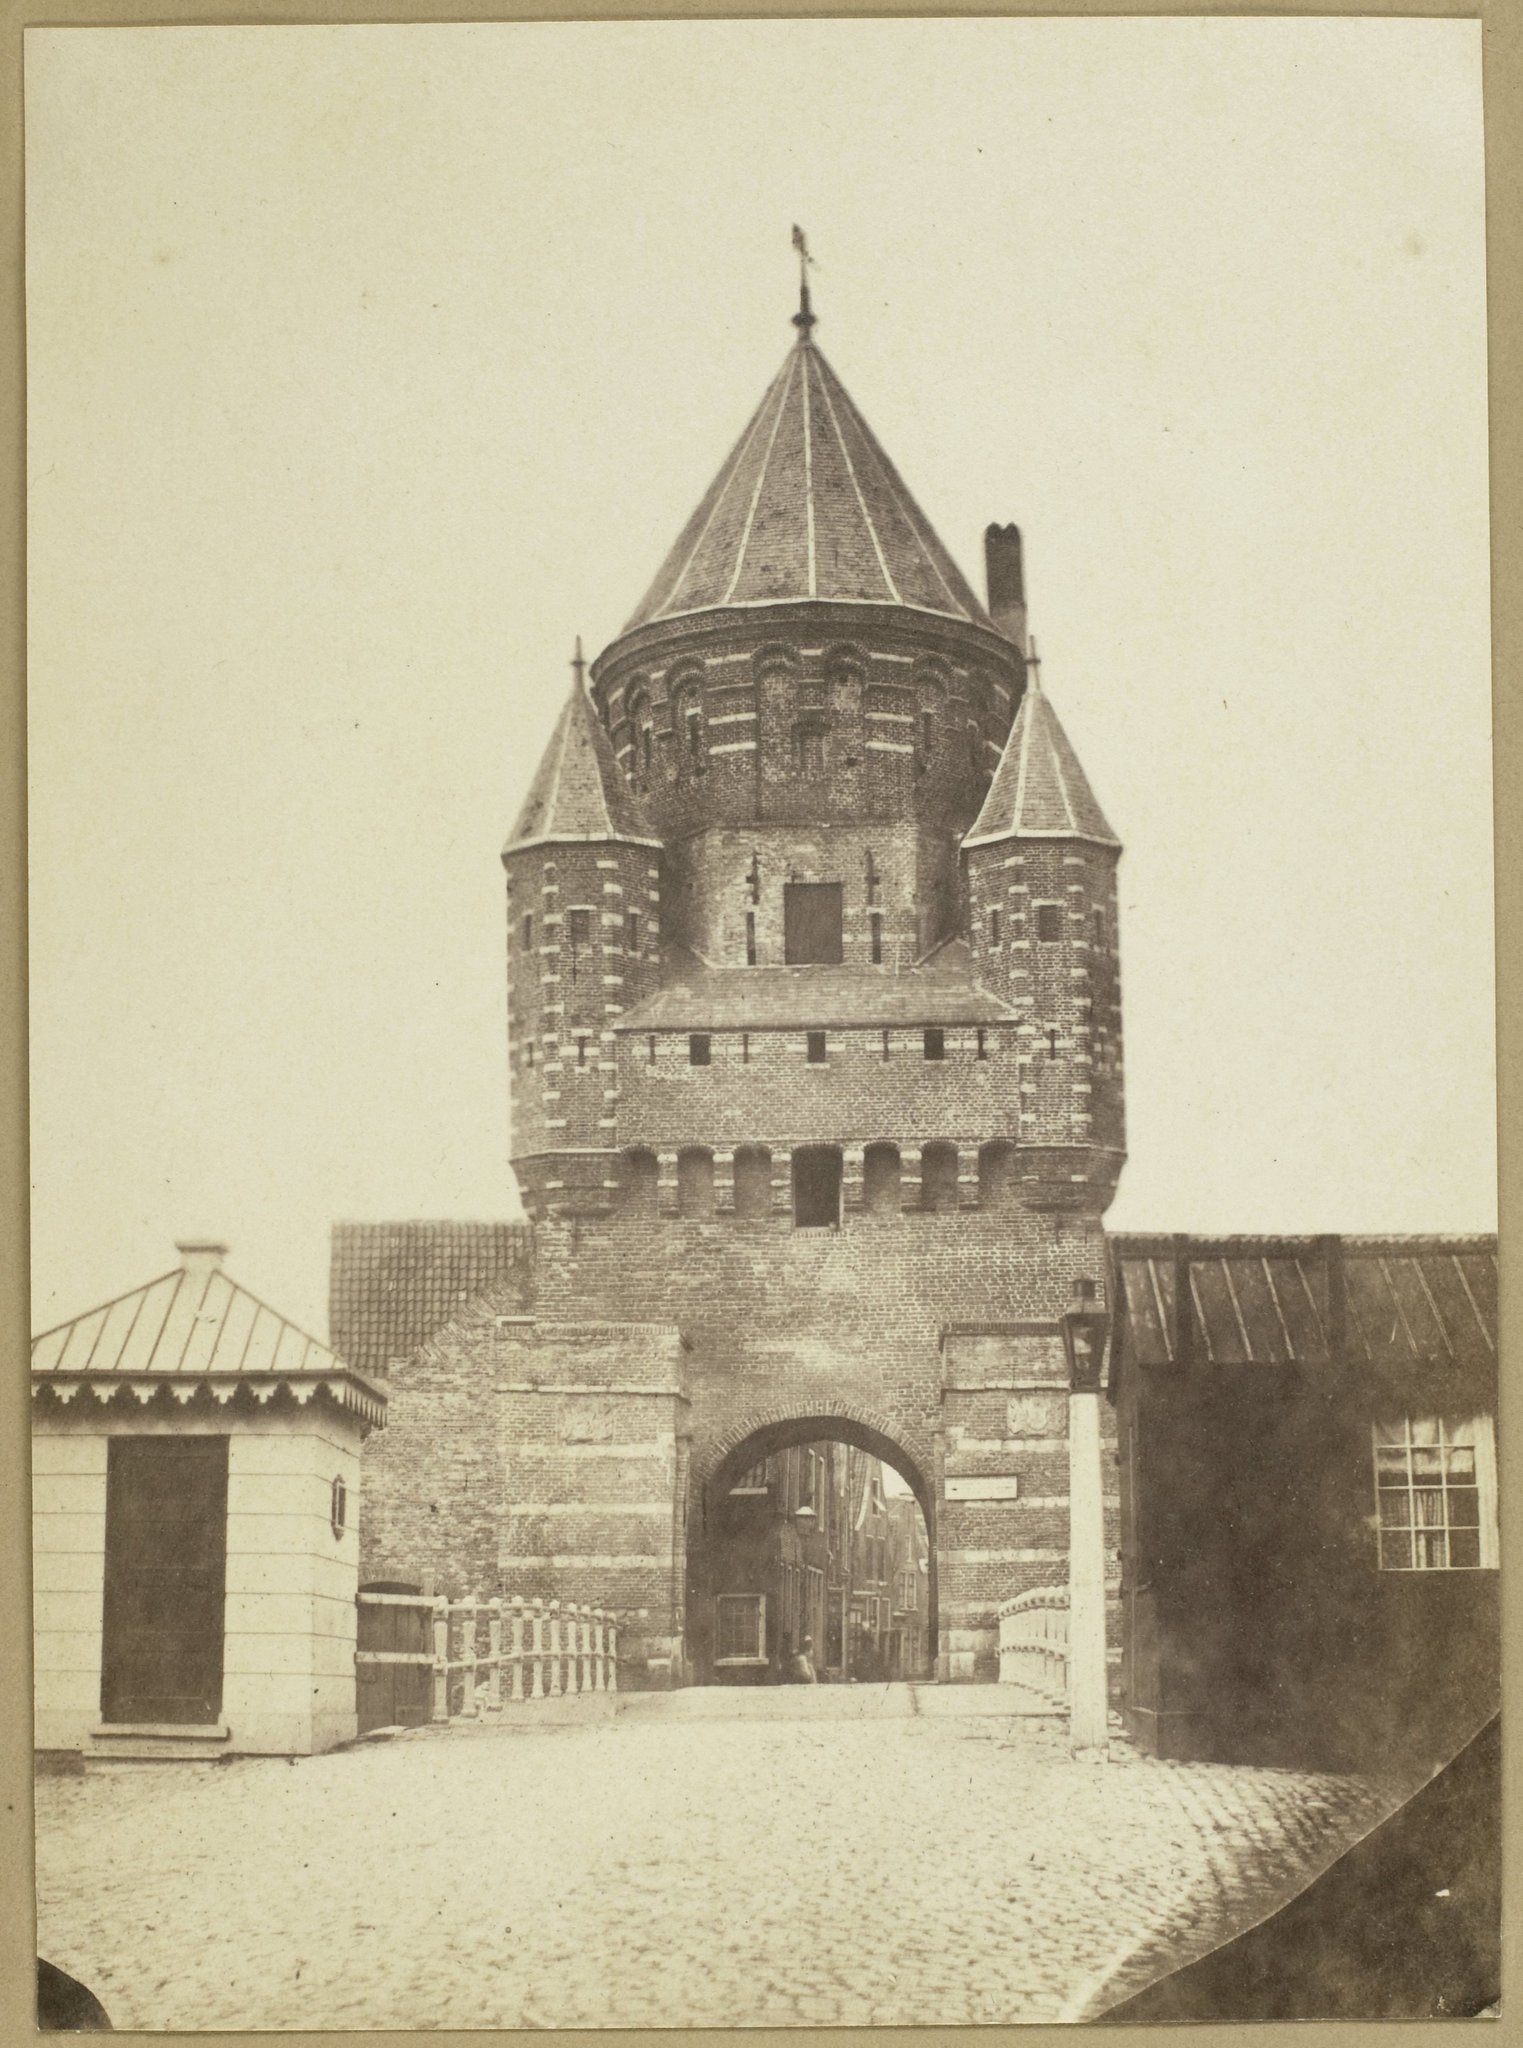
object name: photograph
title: Gezicht op de Kleine Houtpoort, Haarlem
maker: eduard isaac asser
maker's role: amateurfotograaf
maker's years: 1809-1894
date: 1855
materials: cardboard, paper, photographic support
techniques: salted paper print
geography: amsterdam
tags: kleine houtpoort